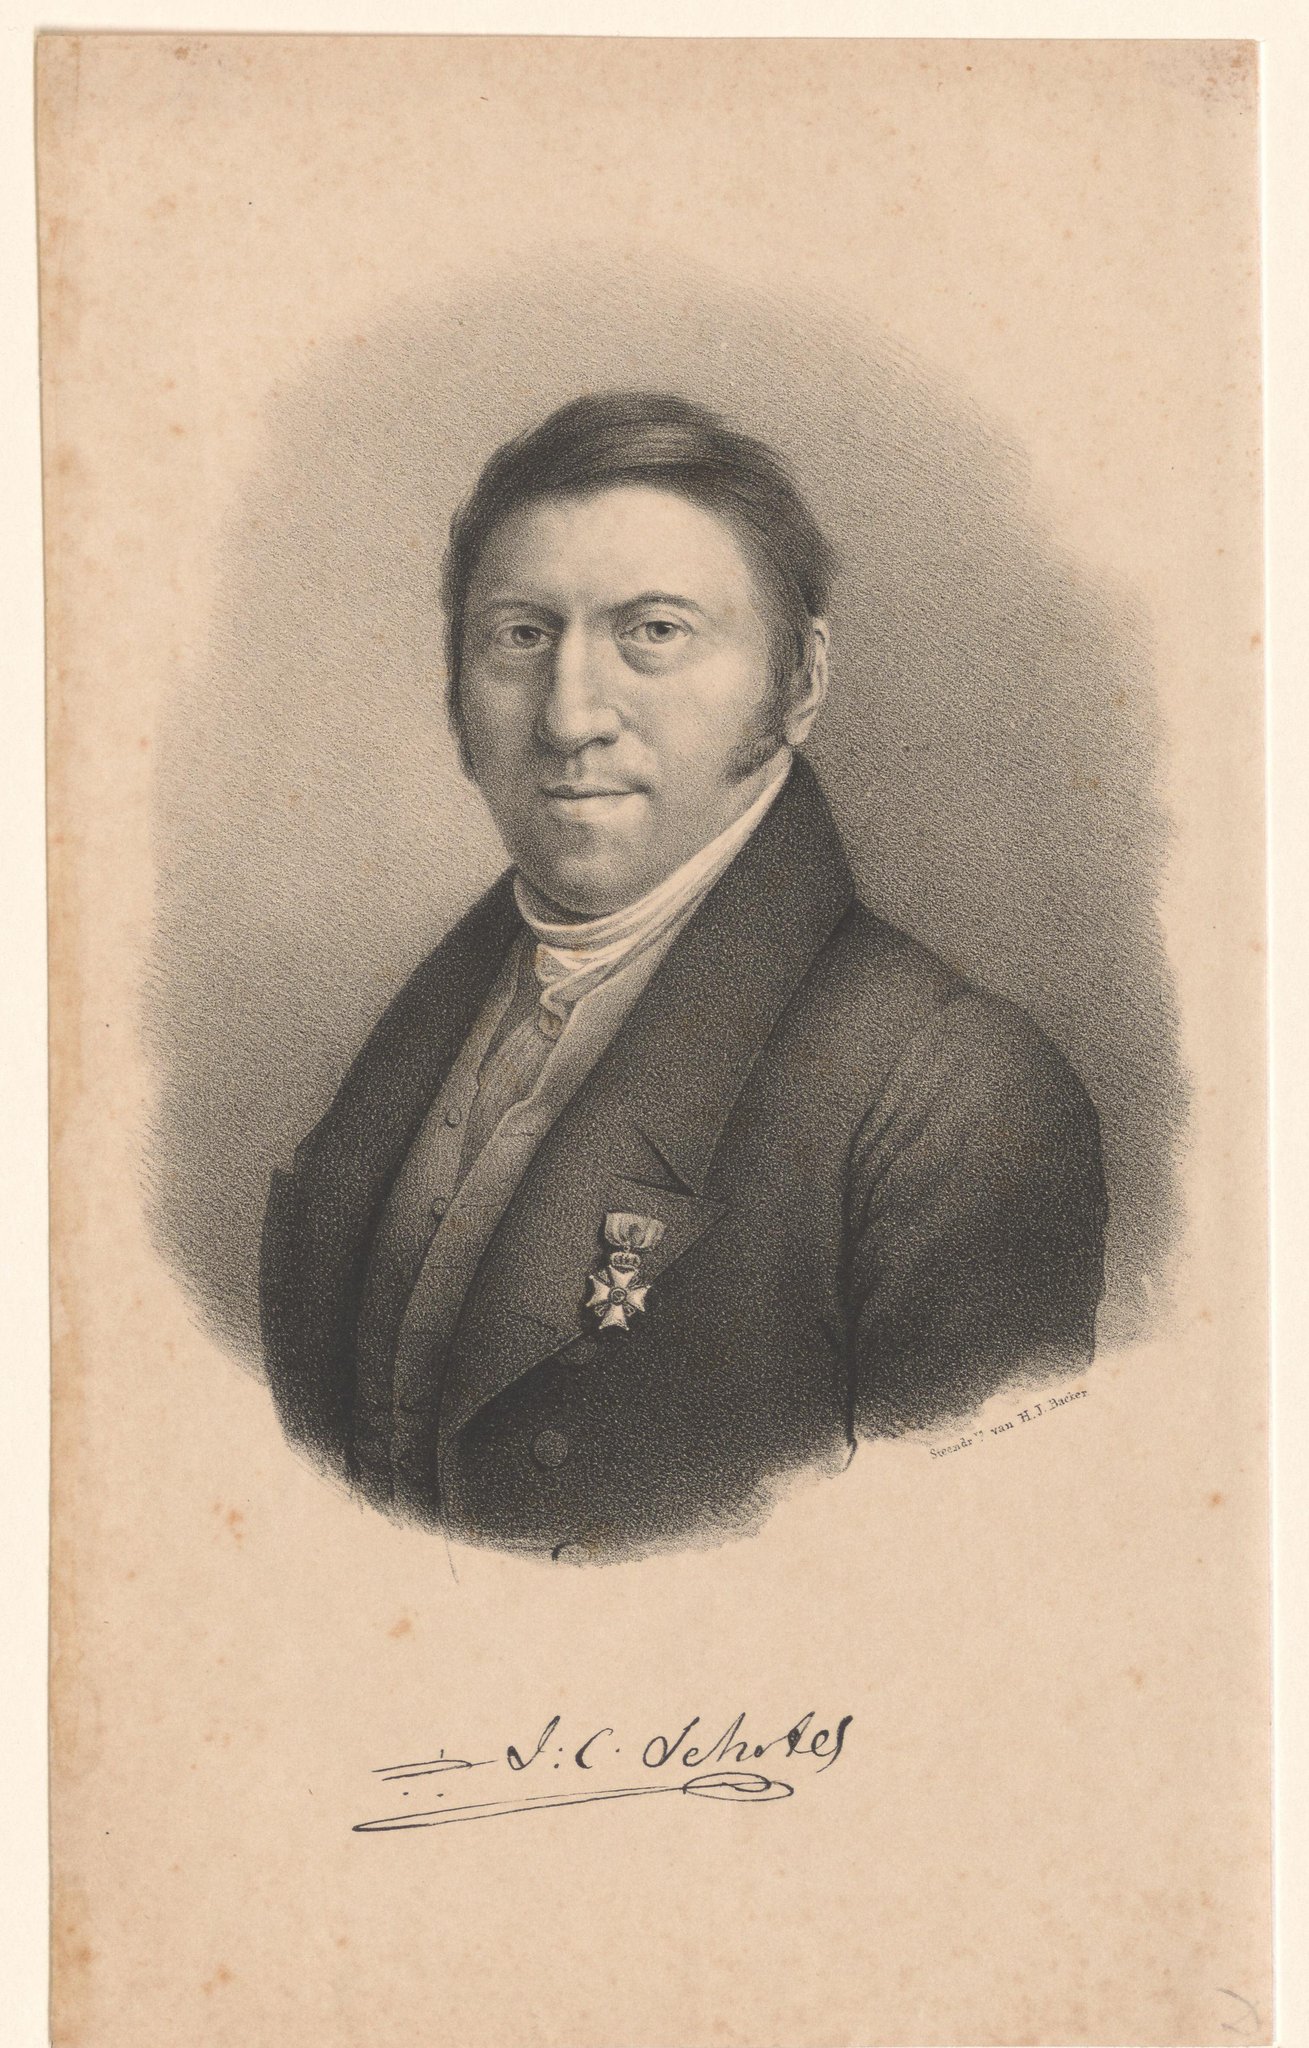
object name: print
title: Portret van Johannes Christiaan Schotel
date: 1822-1845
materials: paper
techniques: lithograph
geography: dordrecht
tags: painter, print maker, draughtsman, johannes christiaan schotel, historical persons, portrait, self-portrait of painter